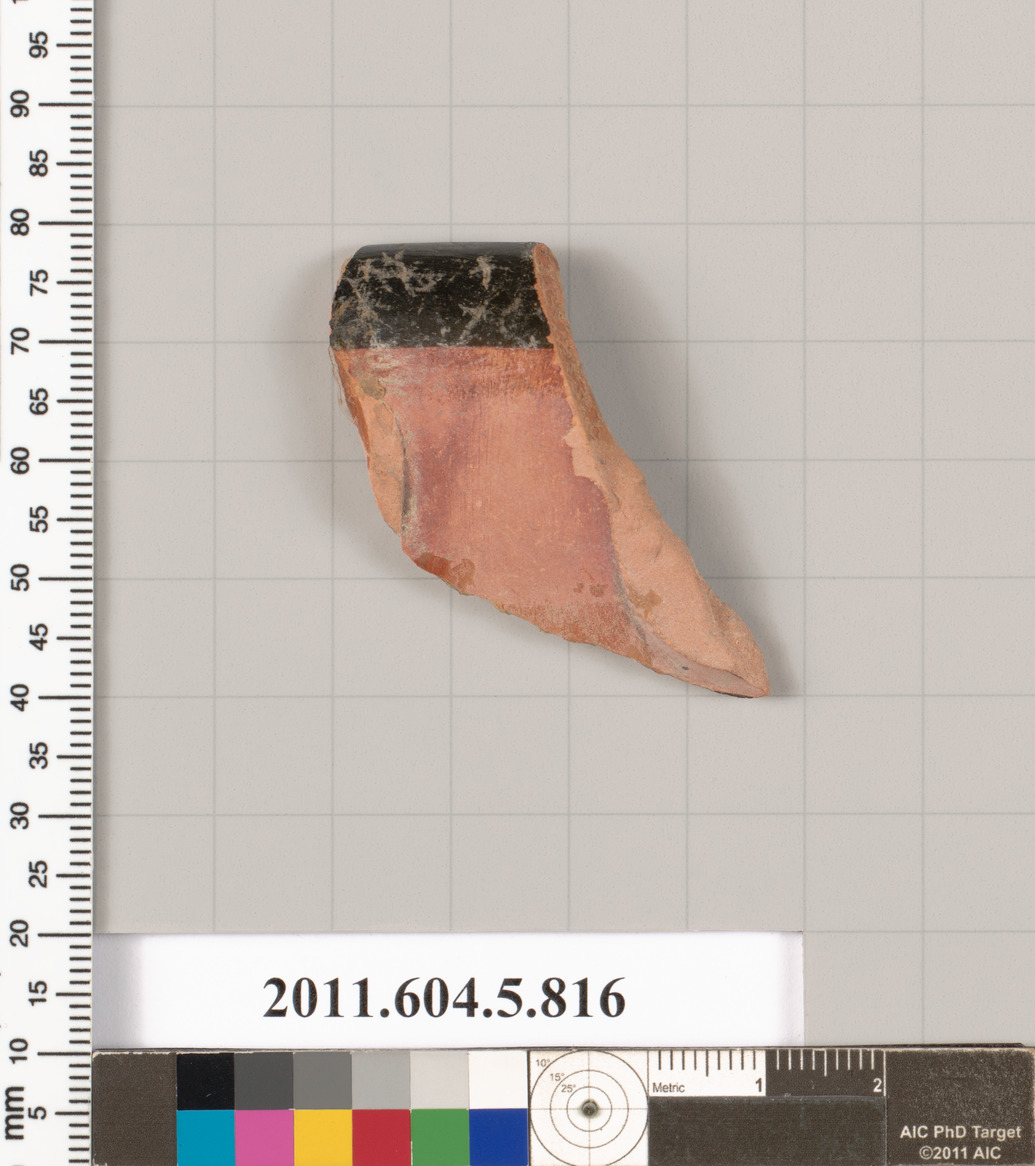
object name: kylix fragment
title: Terracotta rim fragment of a kylix (drinking cup)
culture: greek, attic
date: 600-401 BCE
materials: terracotta